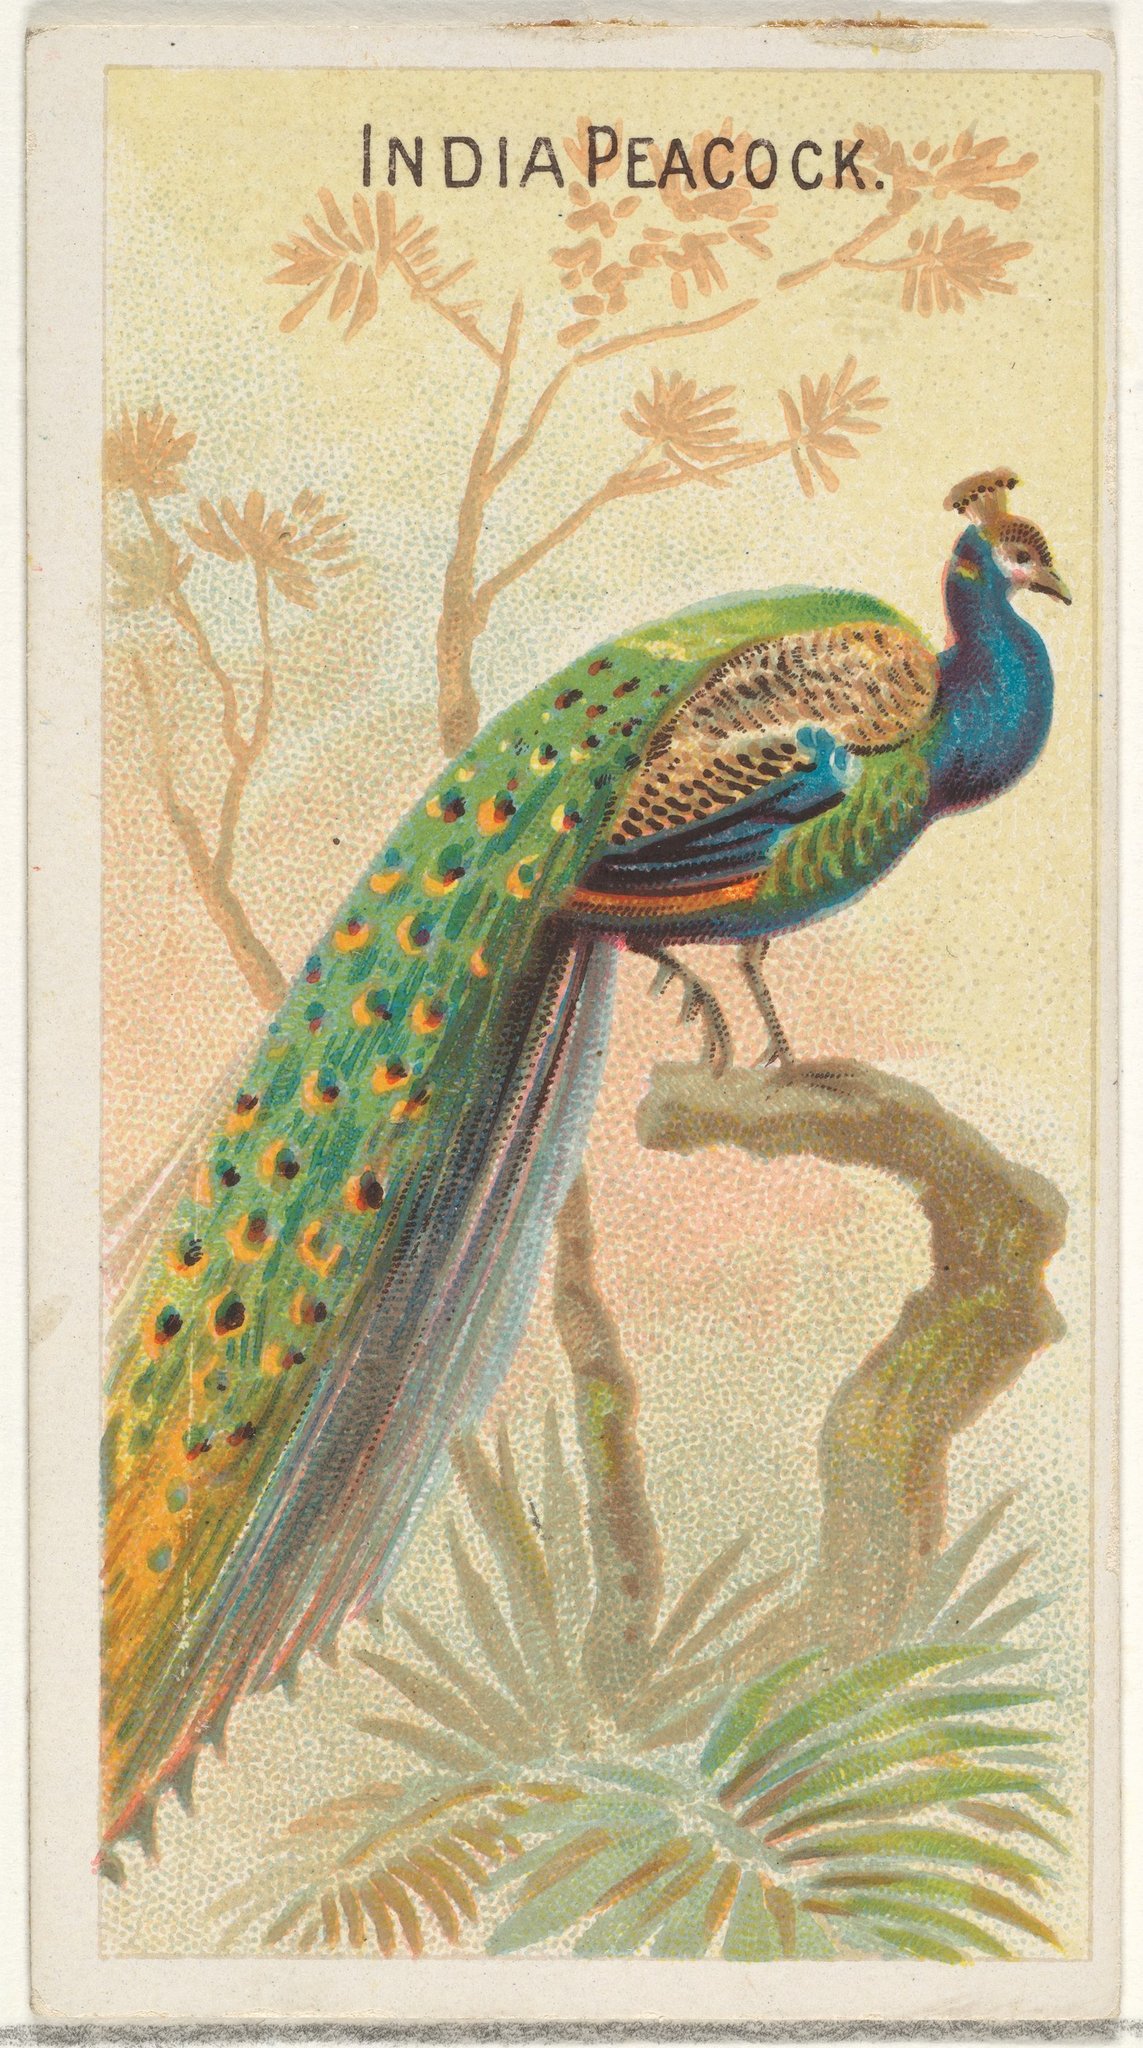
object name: print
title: India Peacock, from the Birds of the Tropics series (N5) for Allen & Ginter Cigarettes Brands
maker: allen & ginter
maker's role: publisher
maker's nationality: american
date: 1889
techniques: color lithograph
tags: peacocks